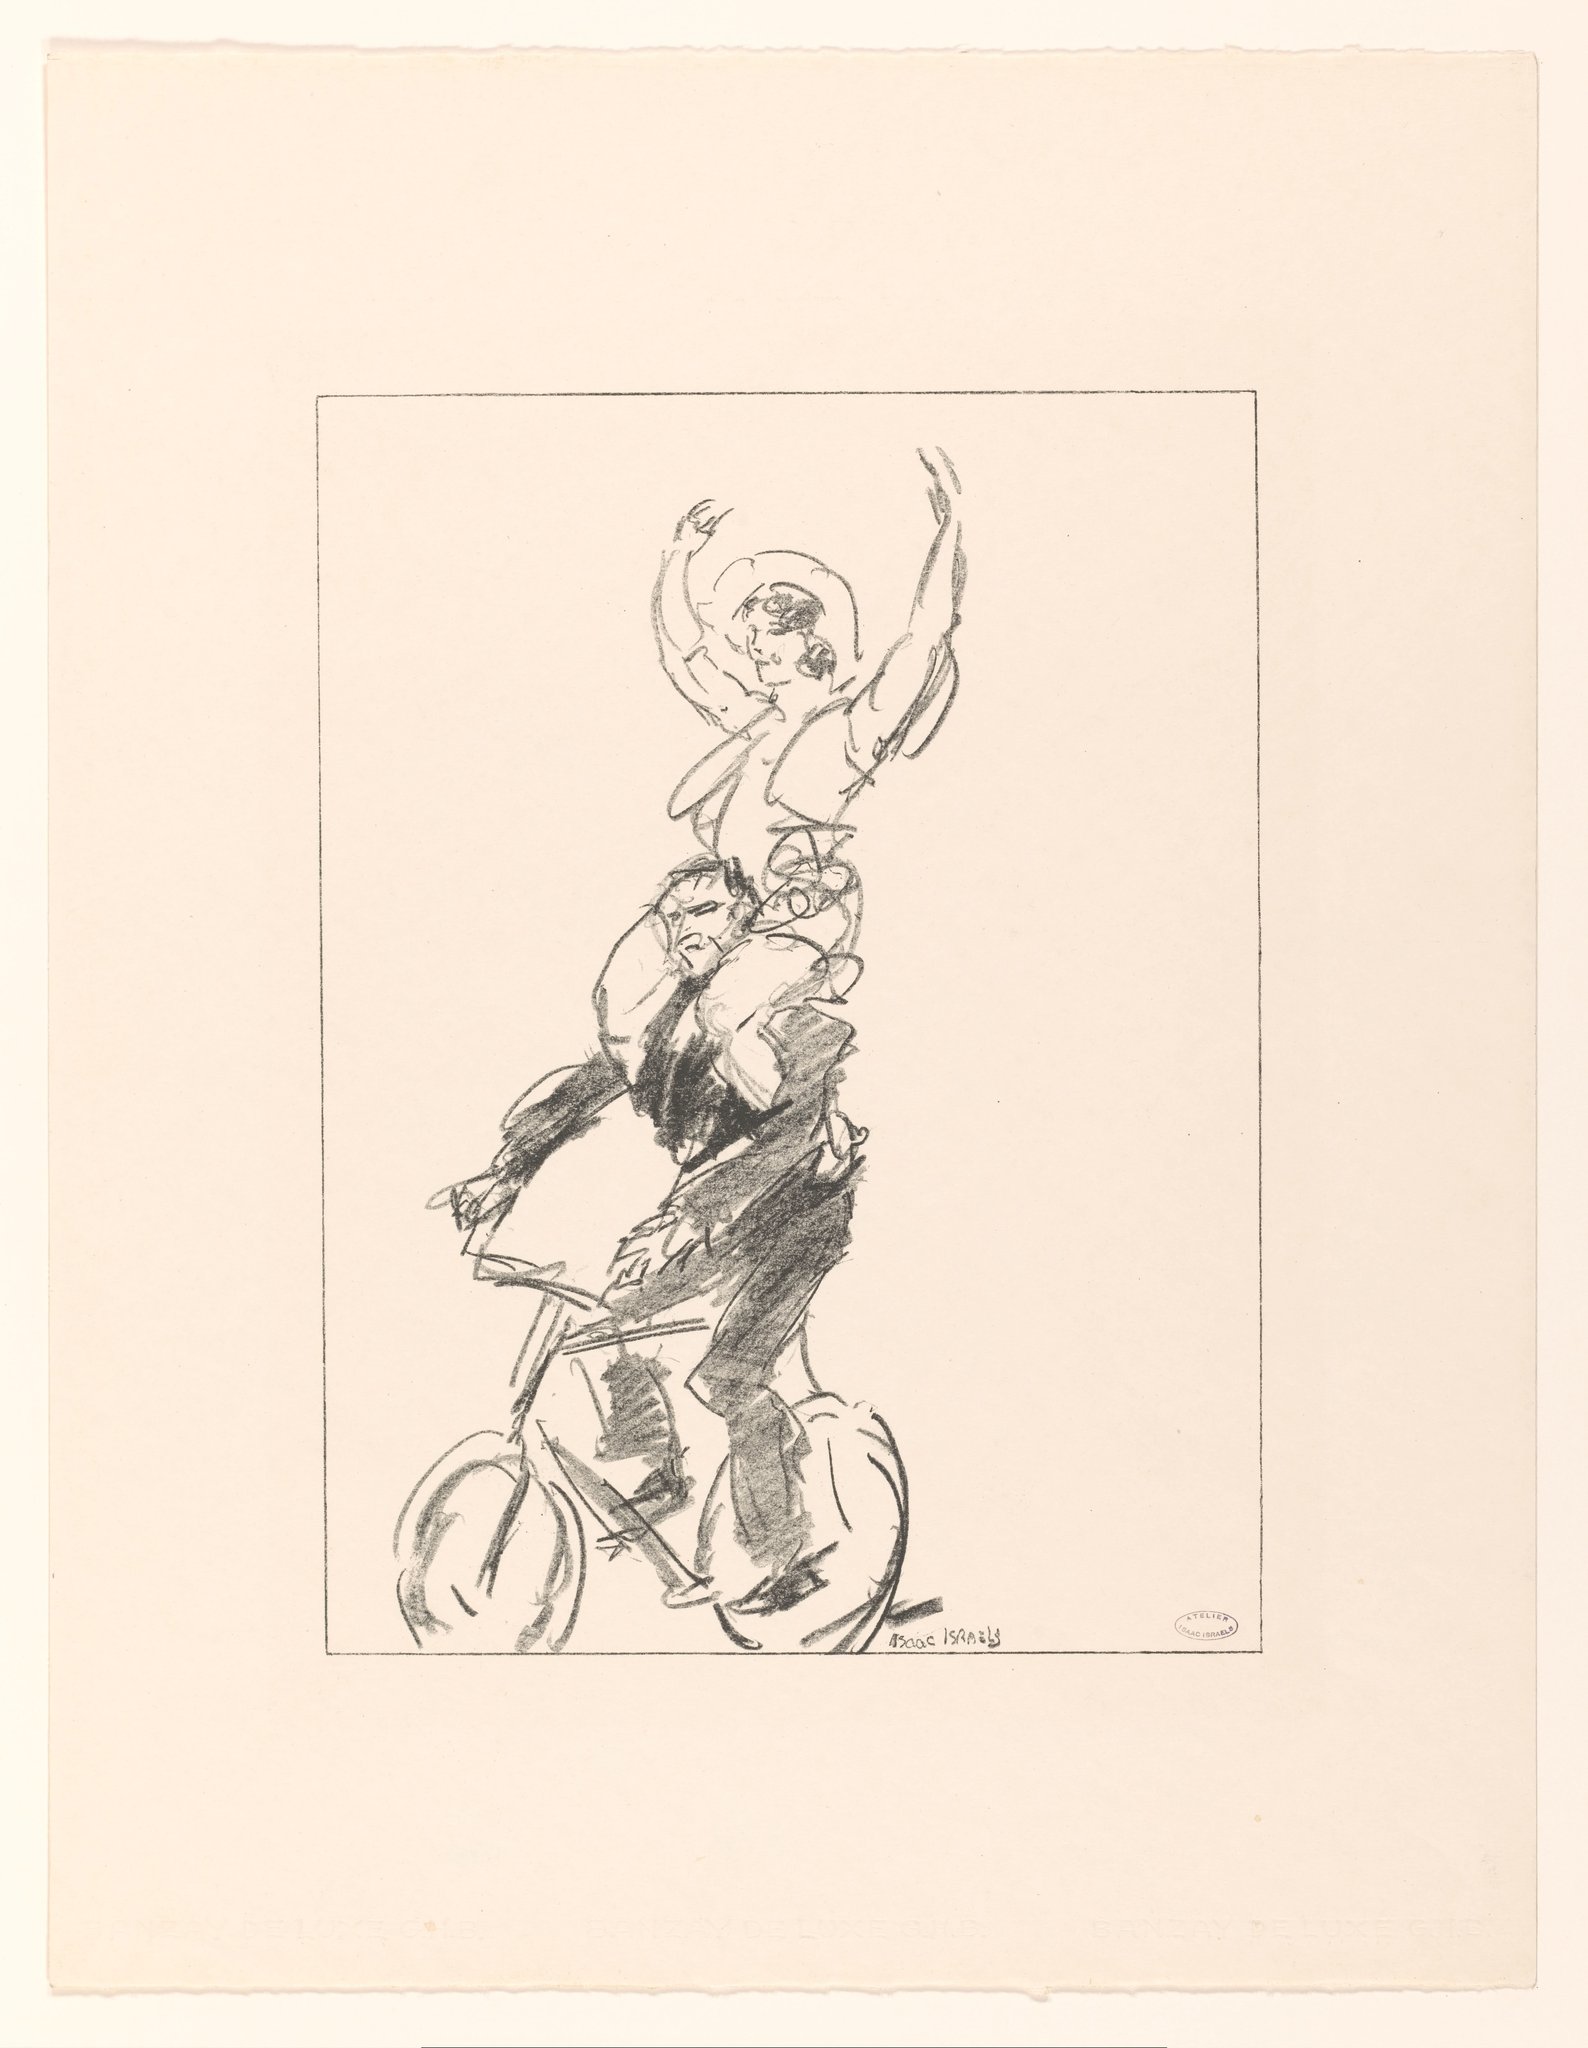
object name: print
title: Acrobaat op de schouders bij een fietsende man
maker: isaac israels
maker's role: draughtsman, painter, print maker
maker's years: 1865-1934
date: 1875-1934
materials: paper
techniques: lithograph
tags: acrobat ~ circus, bicycle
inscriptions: collector's mark: Lugt 1402a, collector's mark: Lugt 2228